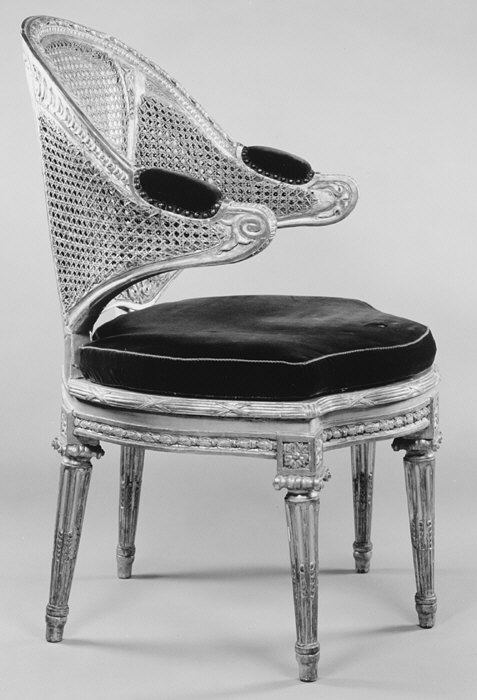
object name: desk chair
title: Desk chair (fauteuil de cabinet)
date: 1770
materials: velvet, wood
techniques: gilding